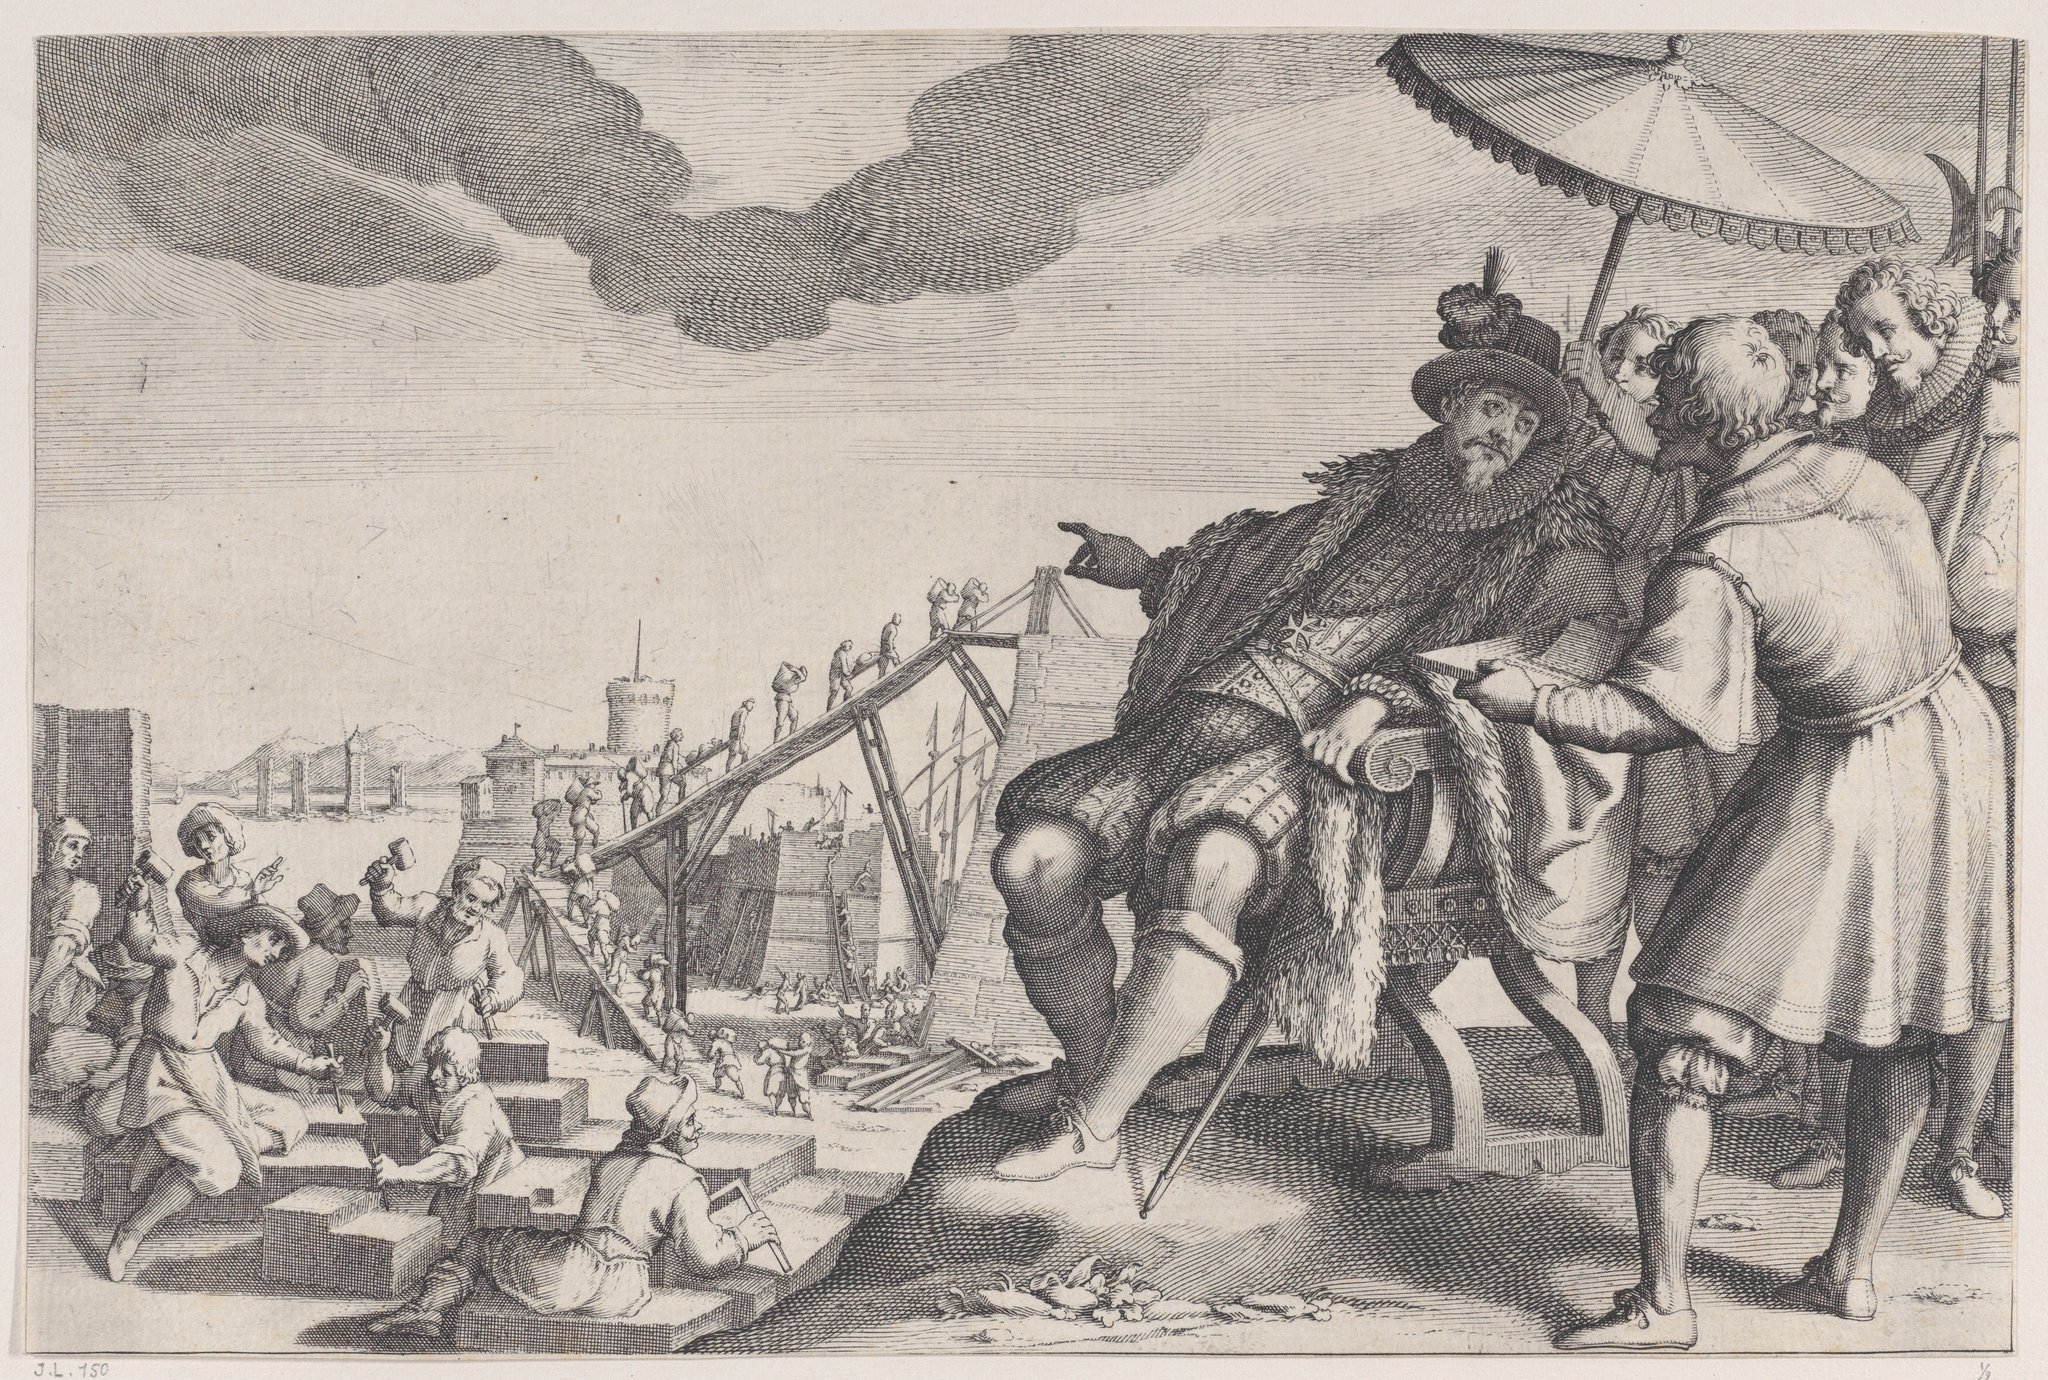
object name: print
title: Le Grand Duc Fait Fortifier le Port de Livourne (The Grand Duke Fortifying the Port of Livourne), from "La Vie de Ferdinand Ier de Médicis série appelée aussi Les Batailles des Médicis" (The Life of Ferdinand I de'Medici also called The Medici Battles)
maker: jacques callot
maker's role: artist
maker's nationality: french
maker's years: 1592-1635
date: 1614-1620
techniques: engraving